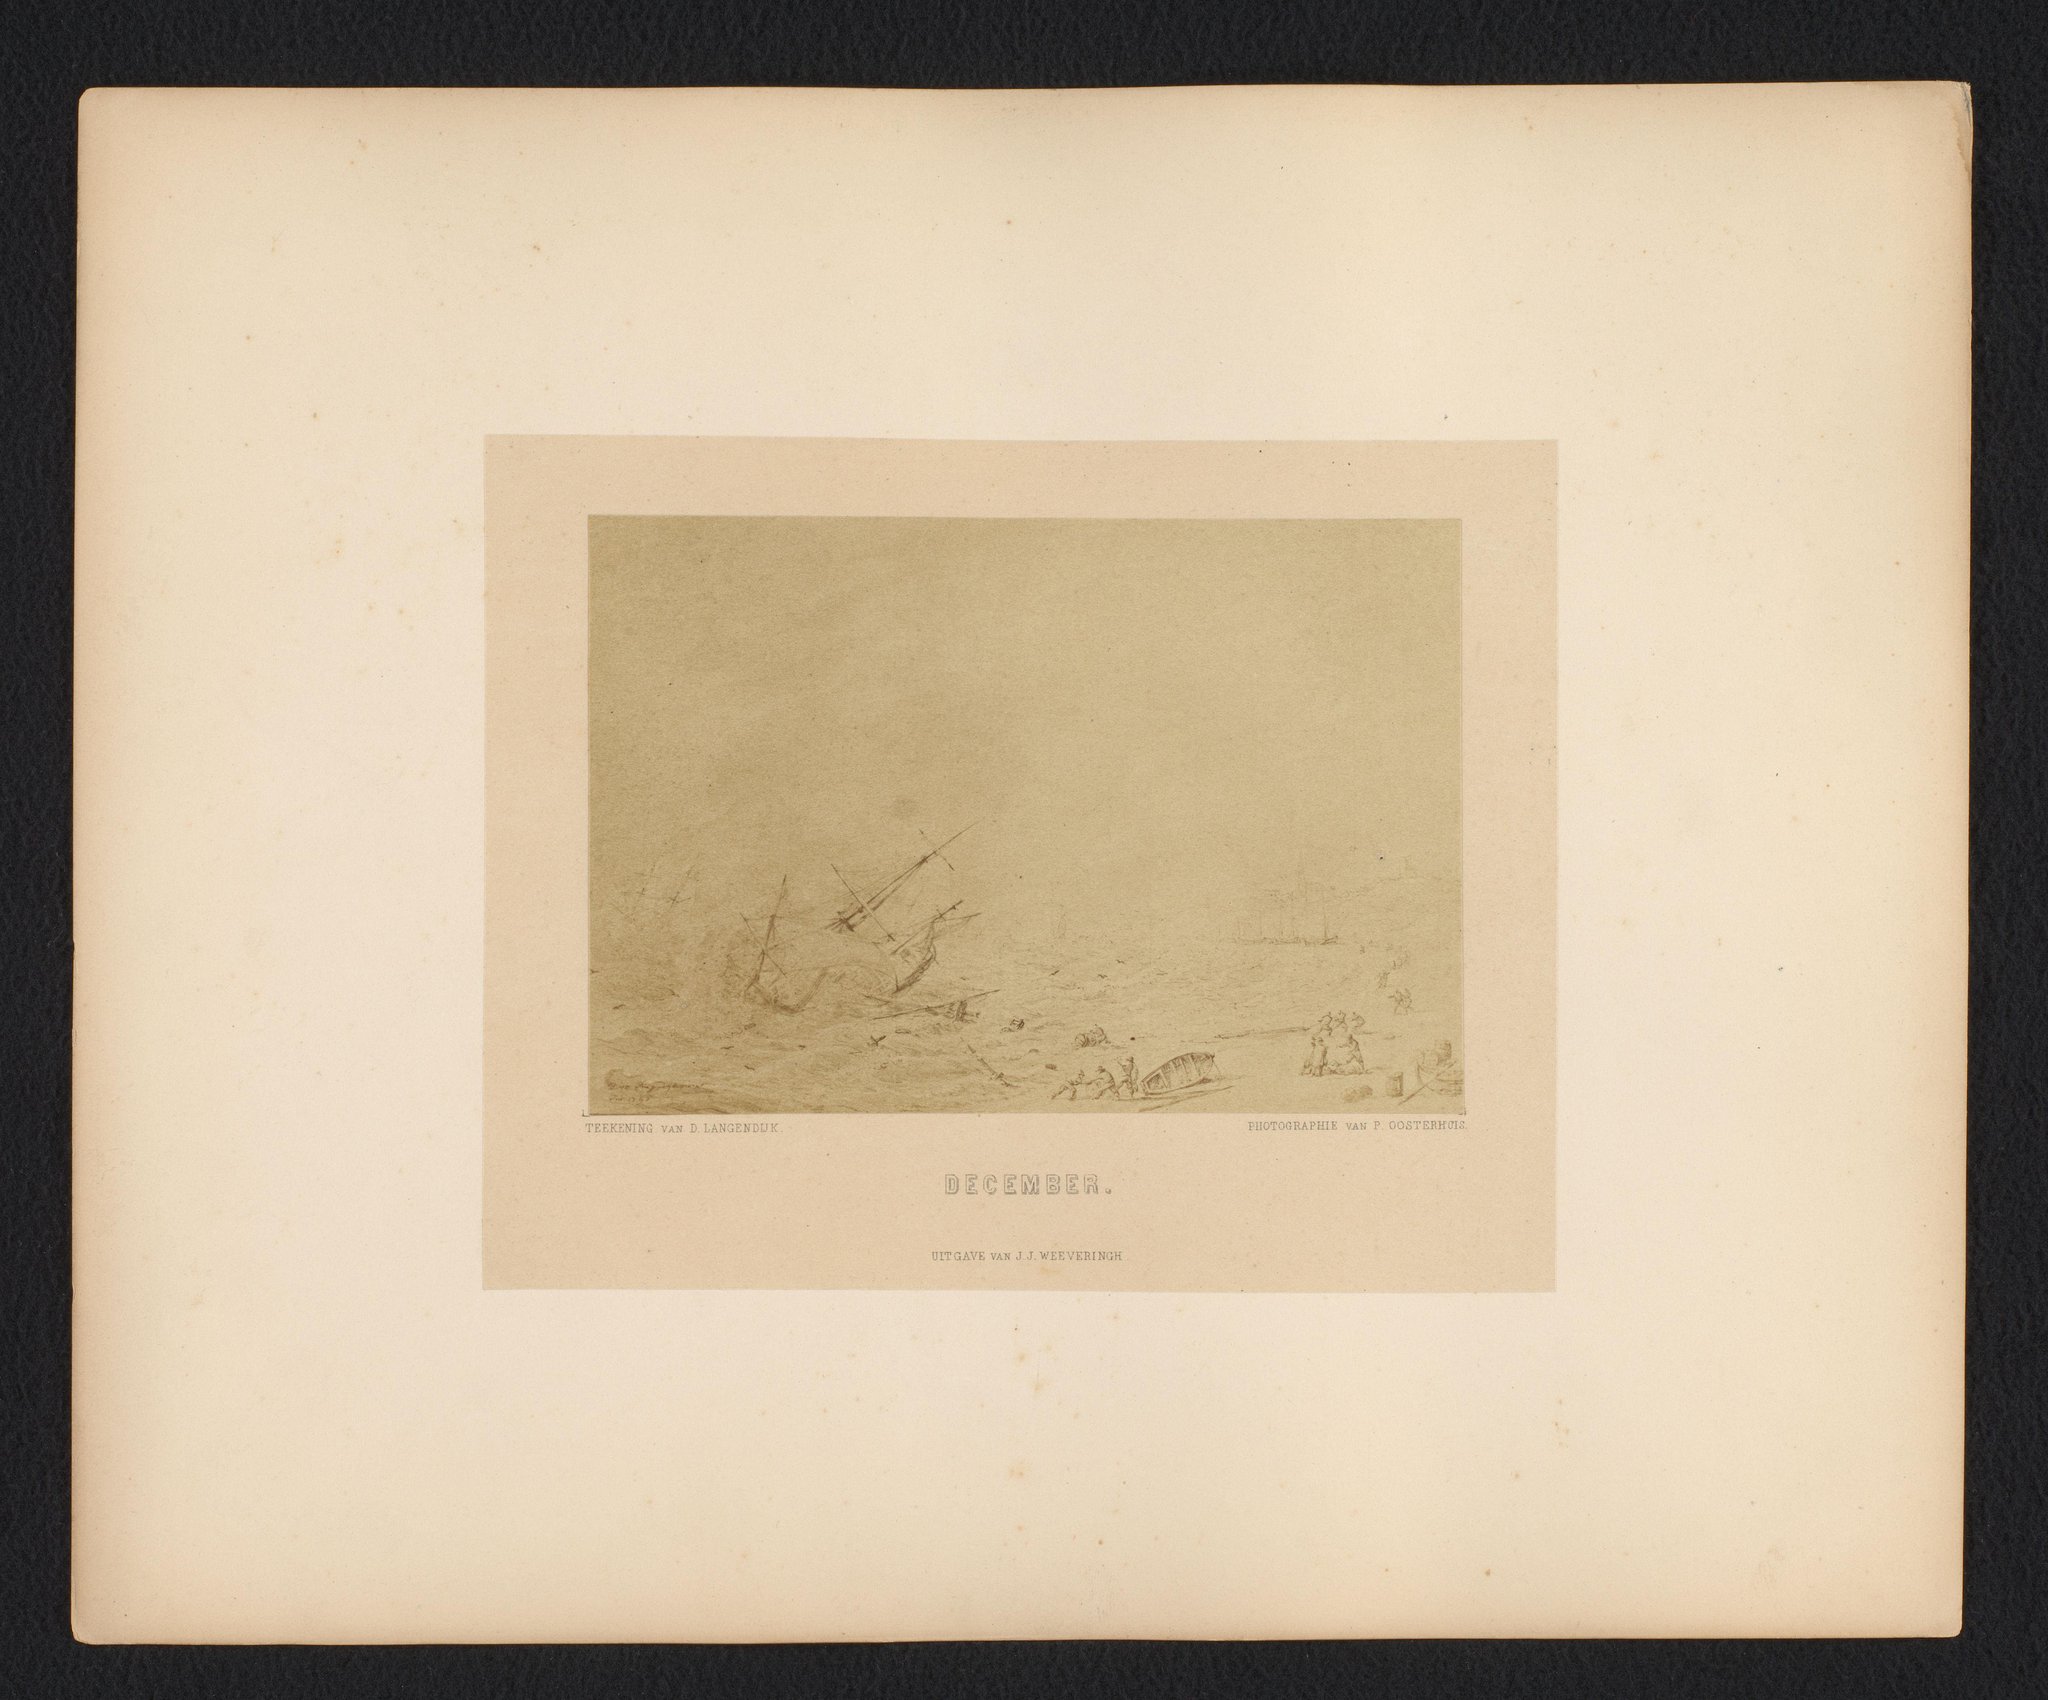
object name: reproduction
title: Fotoreproductie van een tekening van schepen in een storm door Dirk Langendijk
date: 1860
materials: cardboard, paper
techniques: albumen print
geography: haarlem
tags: landscape symbolizing december, storm at sea